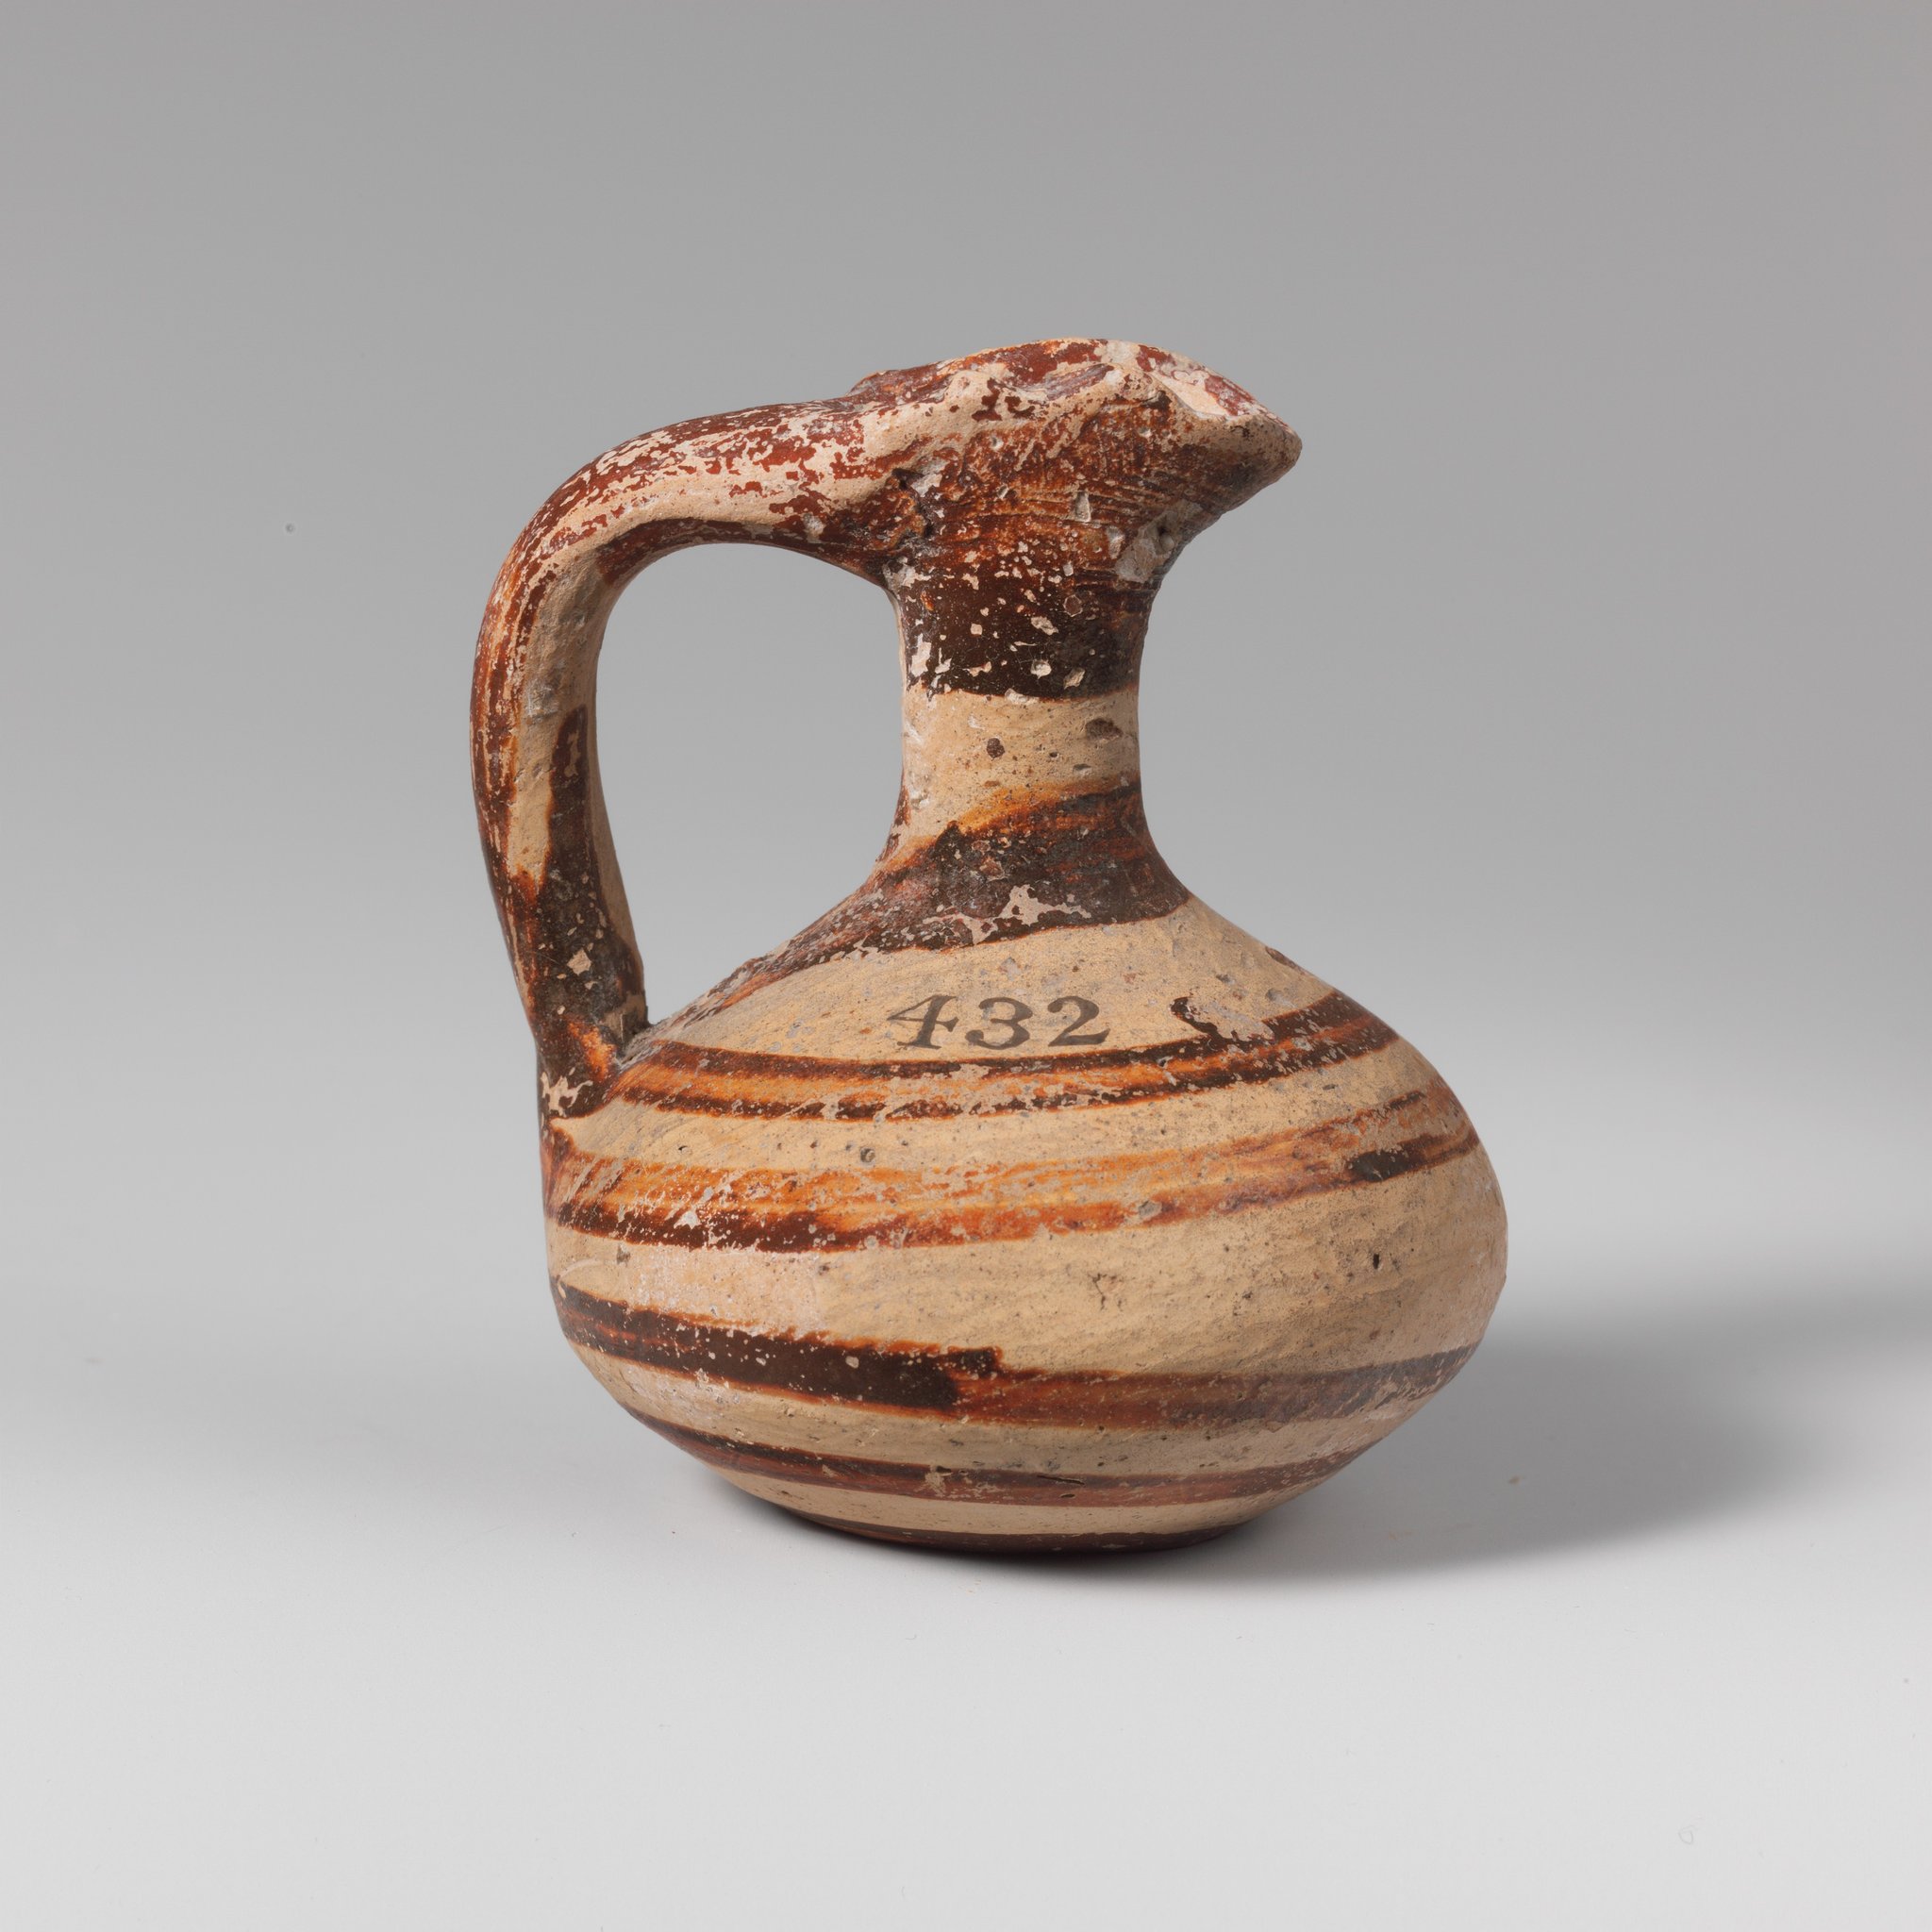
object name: jug, beak spouted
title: Terracotta beak-spouted jug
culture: mycenaean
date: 1600-1050 BCE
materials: terracotta